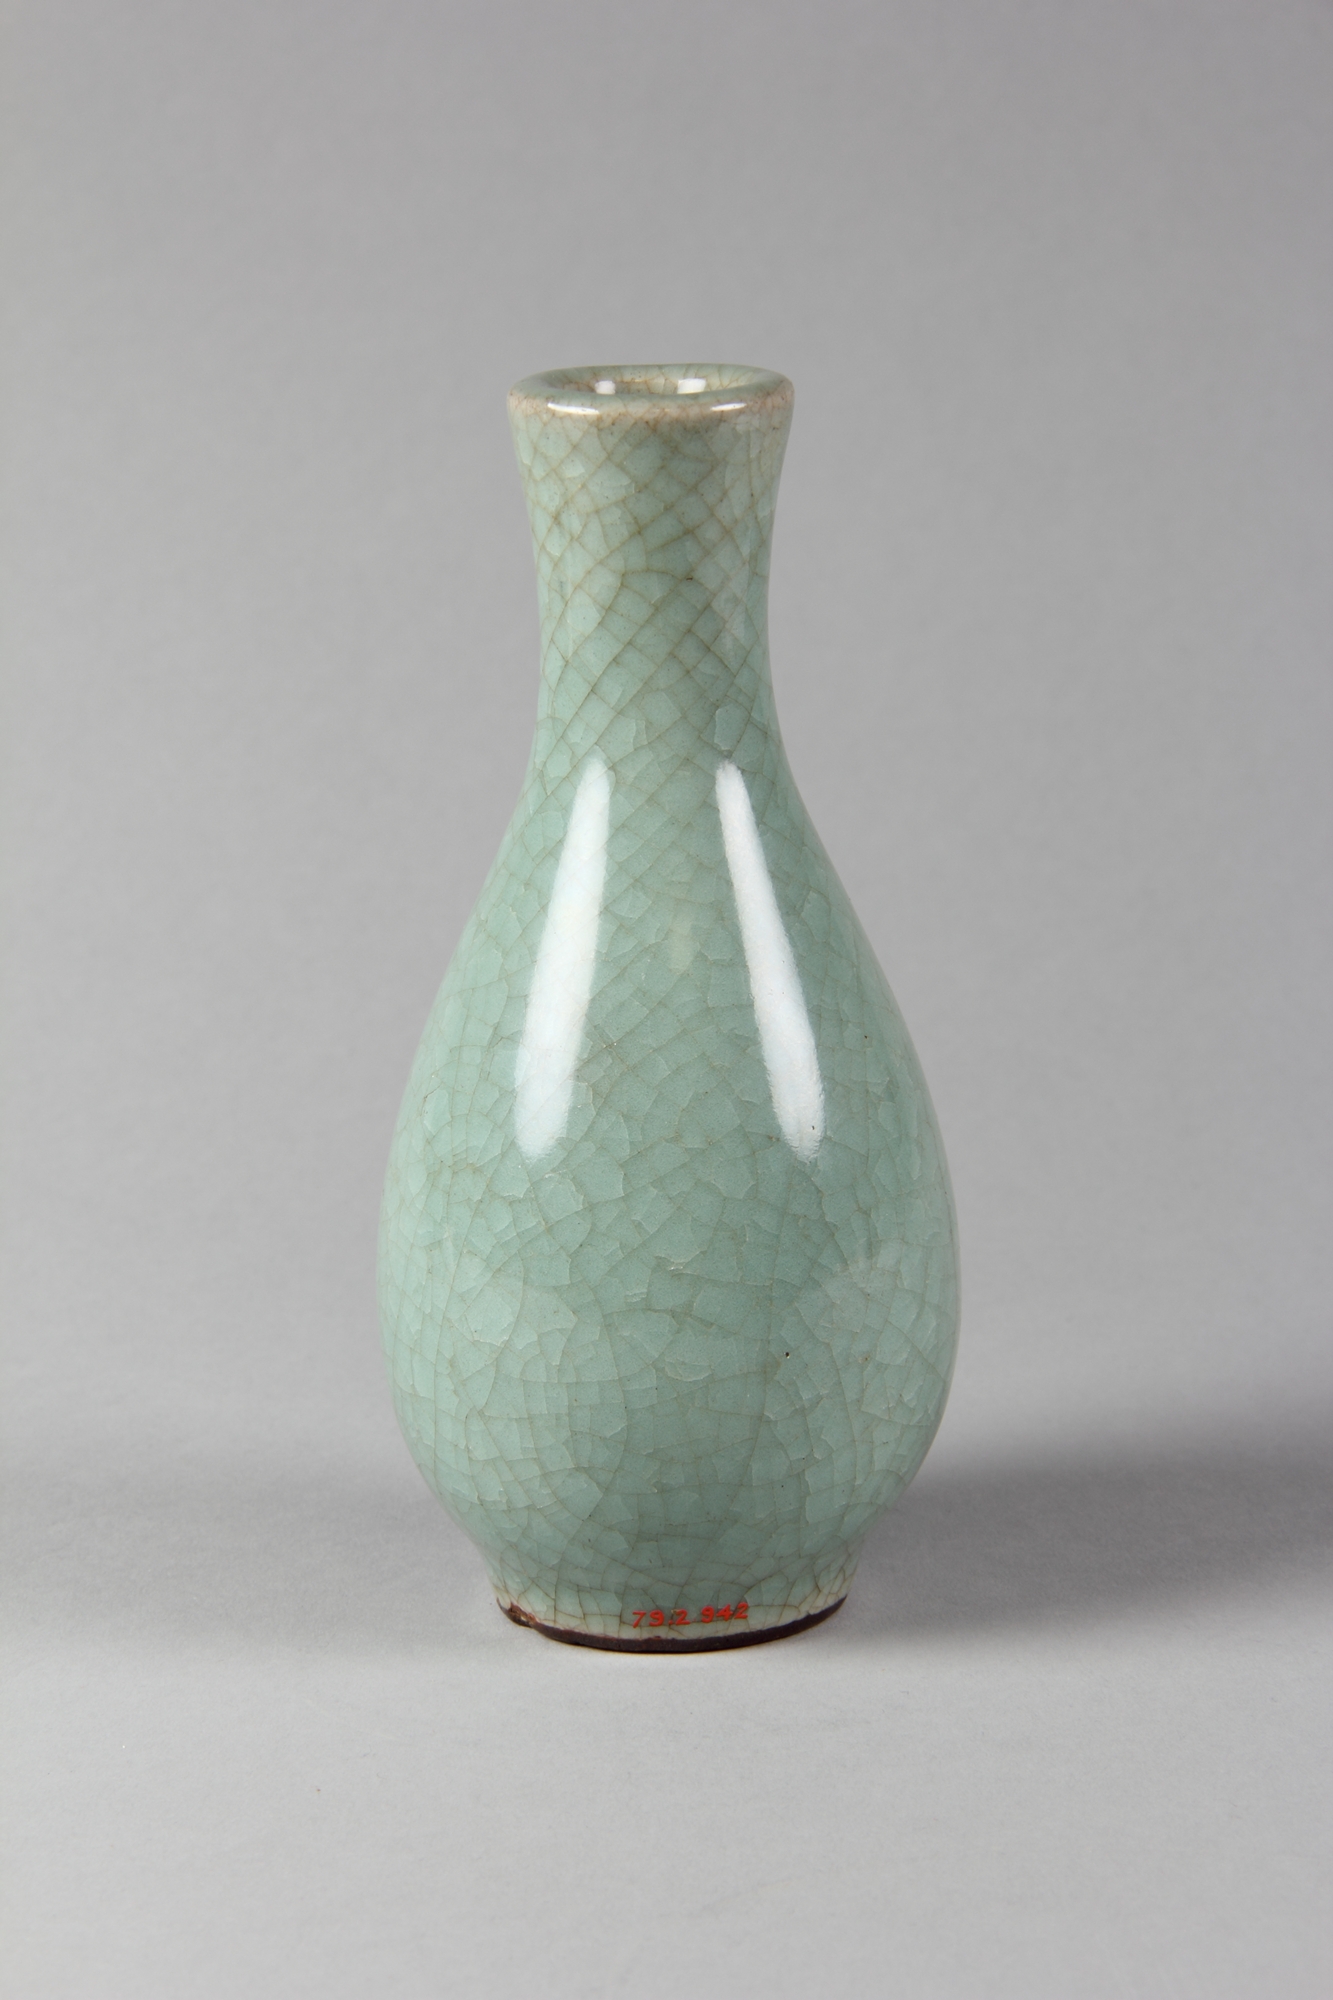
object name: vase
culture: chinese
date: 1801-1850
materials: ceramic glaze, glaze, porcelain